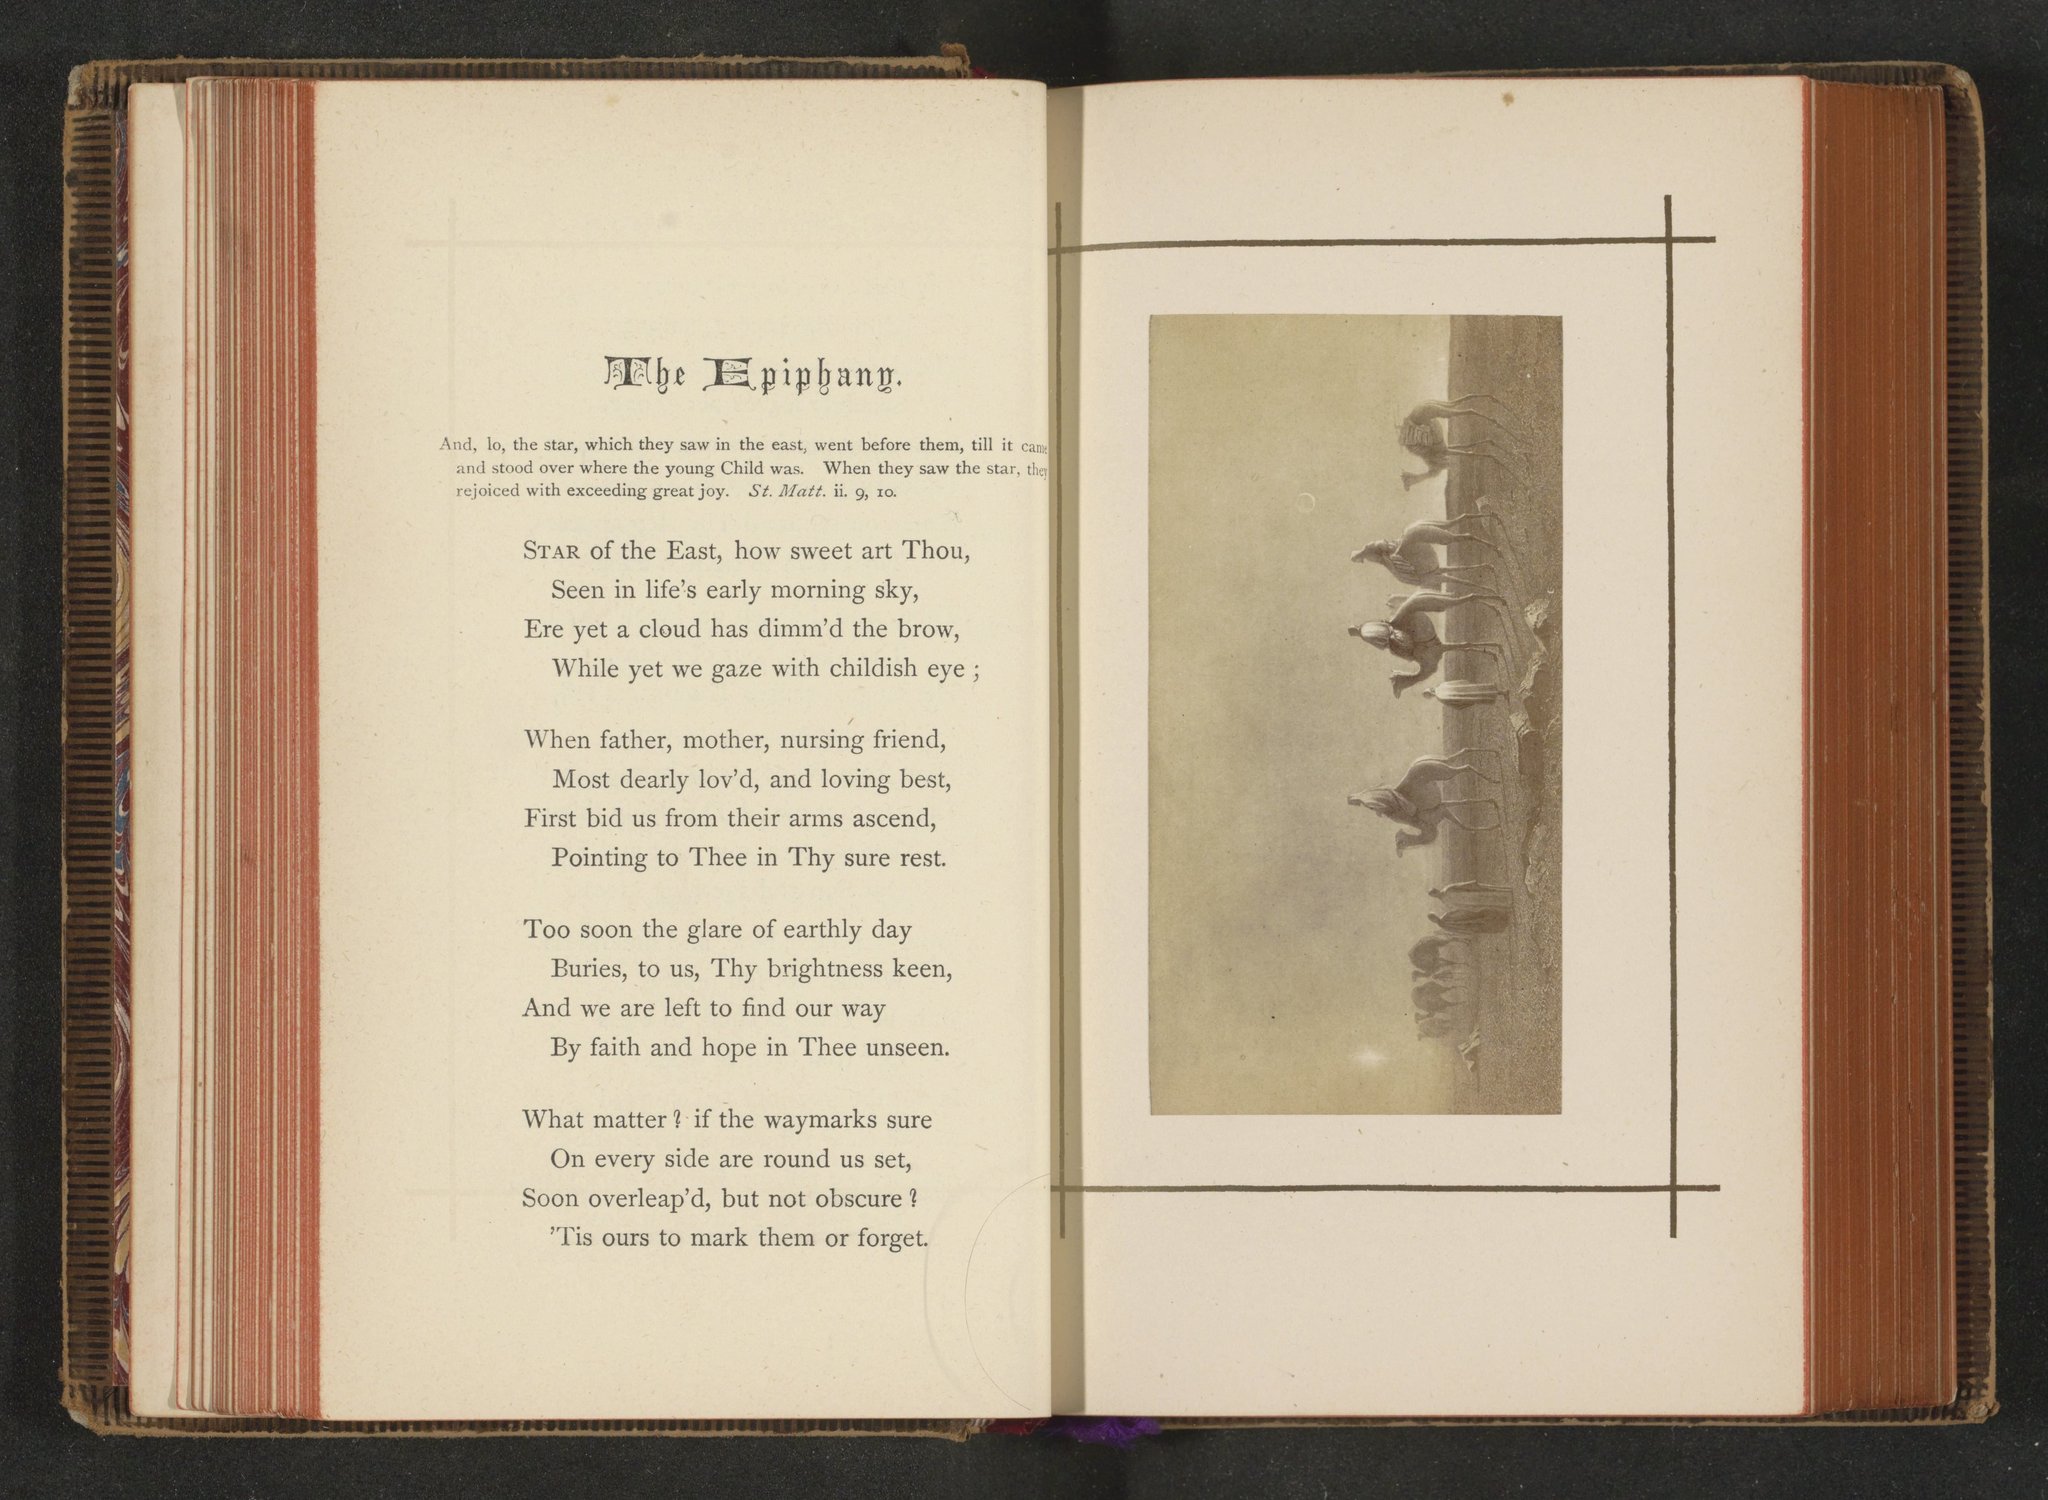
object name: photograph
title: Fotoreproductie van een schilderij, voorstellende de drie koningen op dromedarissen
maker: Anonymous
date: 1865-1870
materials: photographic support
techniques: albumen print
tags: hoofed animals: dromedary, journey of the three wise men to jerusalem